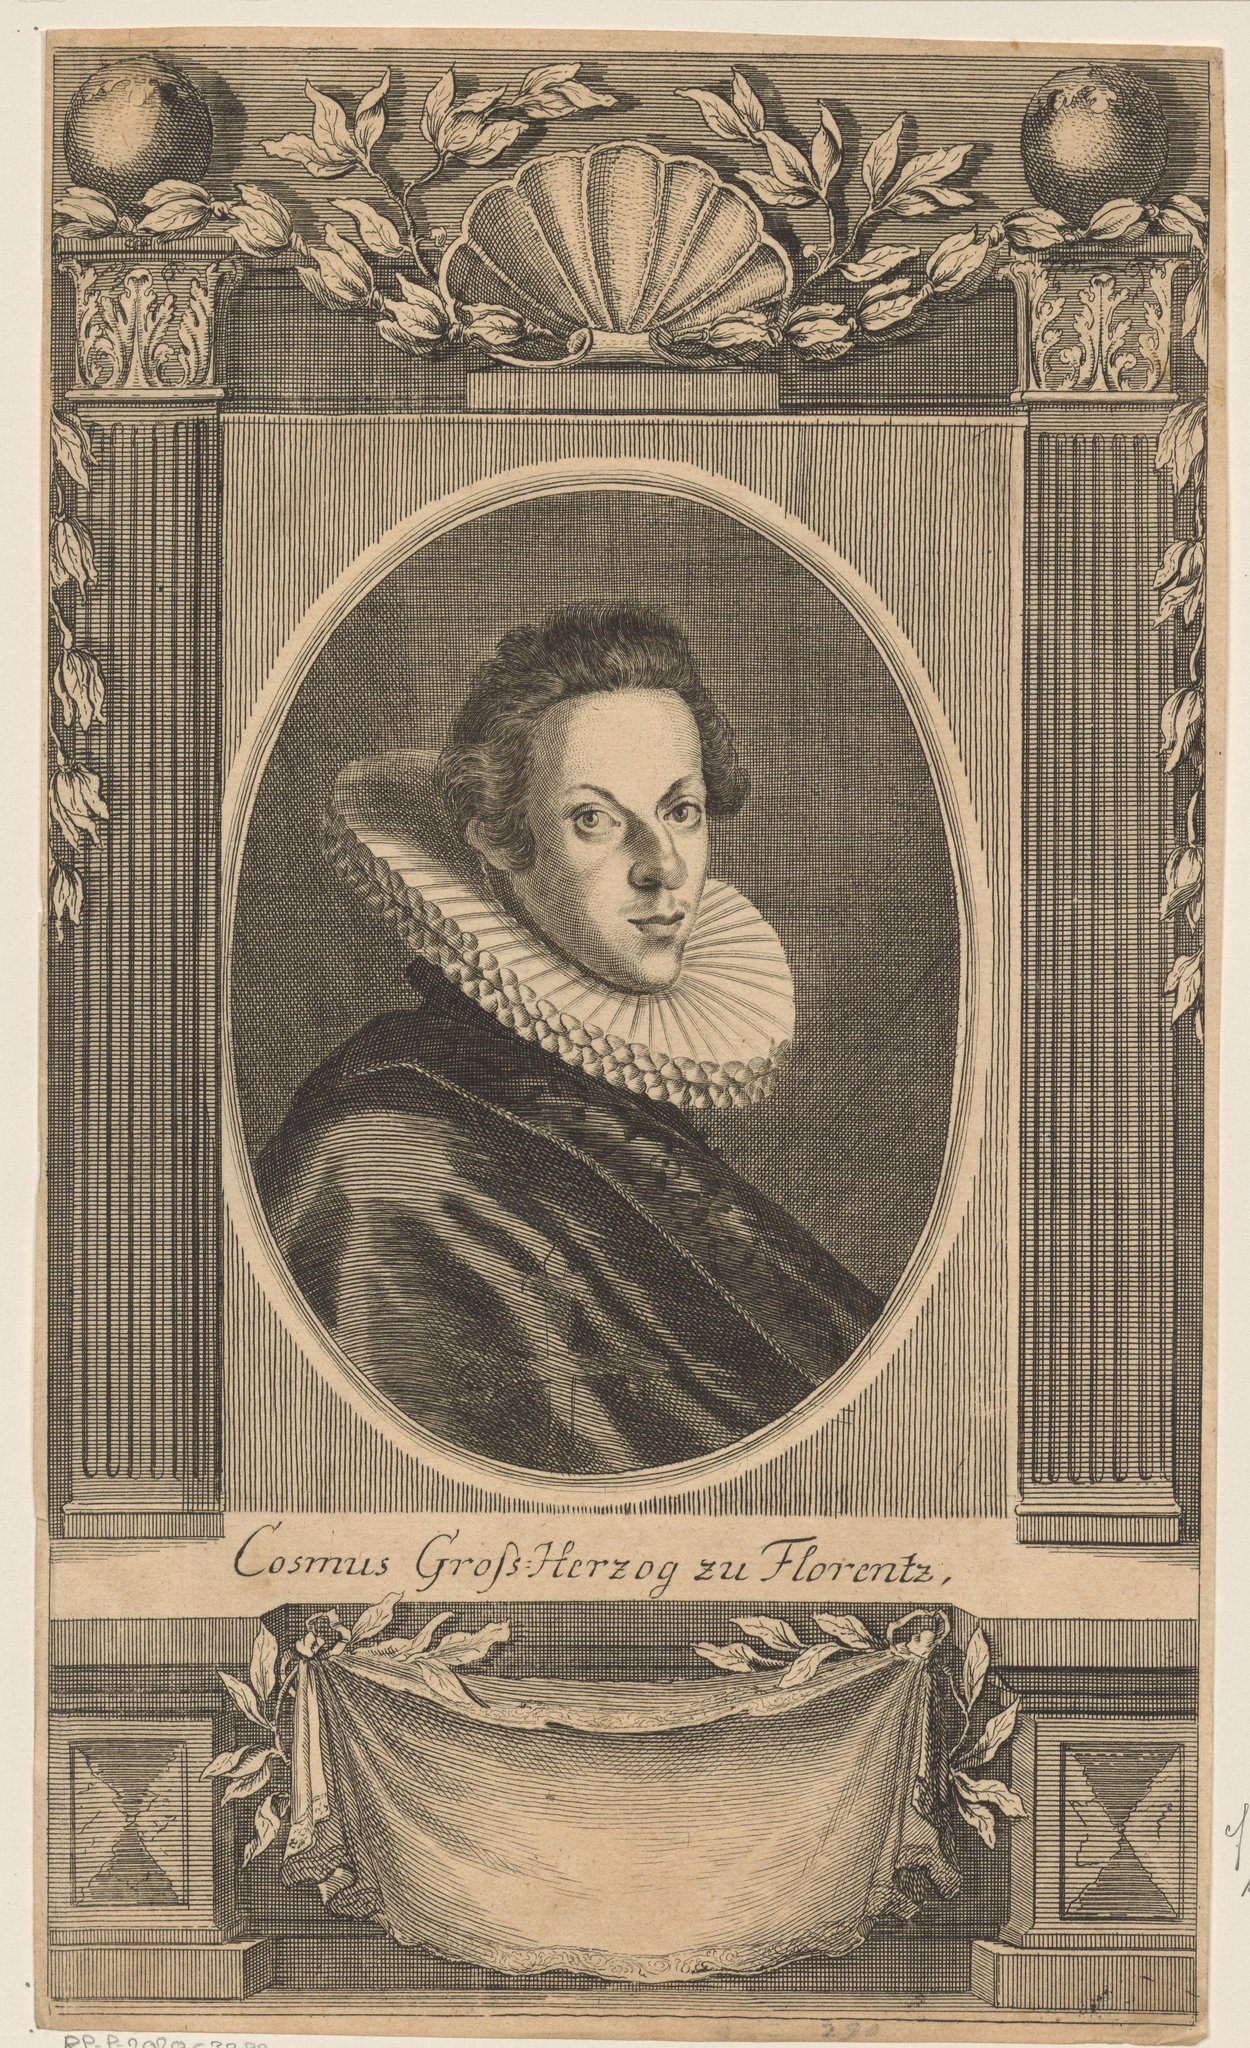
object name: print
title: Portret van Cosimo II de'Medici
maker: Anonymous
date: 1700-1749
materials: paper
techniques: engraving, etching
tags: cosimo ii de' medici, historical persons